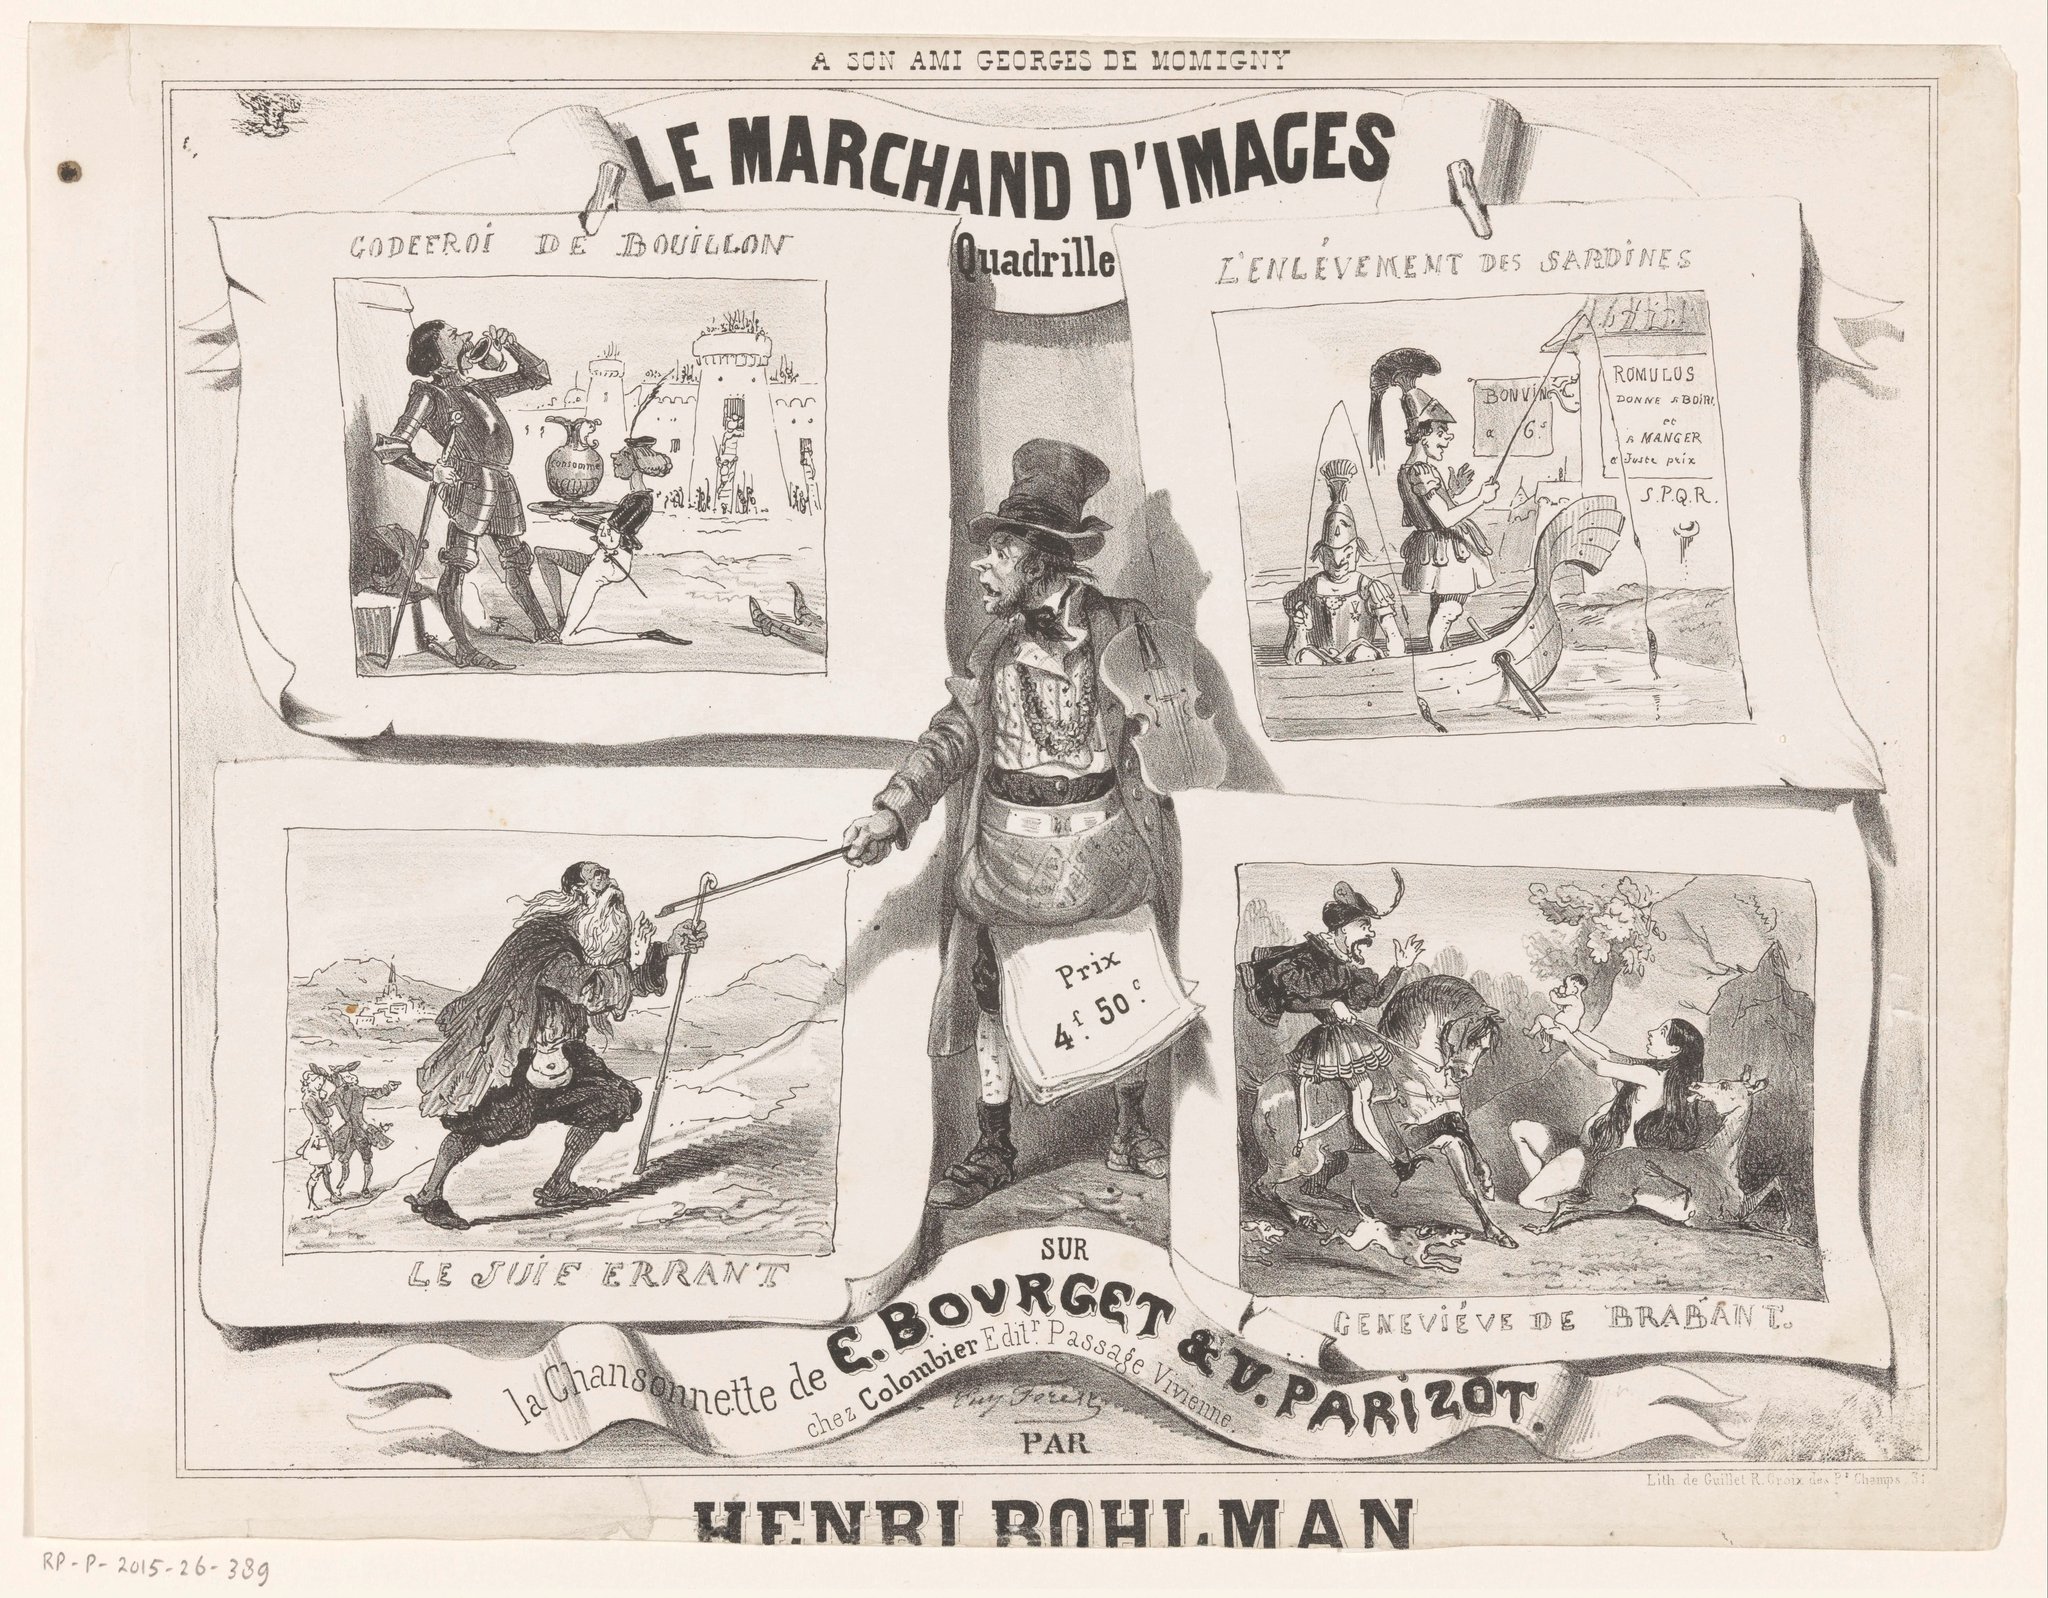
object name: wrapper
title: Prenthandelaar met viool omringd door vier prenten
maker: eugène hippolyte forest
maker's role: print maker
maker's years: 1808-1866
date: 1842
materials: paper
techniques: lithograph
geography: paris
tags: ahasverus, the wandering jew, genoveva, the graphic arts, violin, fiddle, (story of) romulus and remus, godfrey of bouillon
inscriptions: collector's mark: Lugt 2228, collector's mark: Lugt 4779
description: De prenten tonen: Godfried van Bouillon die een beker bouillon drinkt, Romulus en Remus die vissen op sardines (een persiflage op de Sabijnse maagdenroof), de Wandelende Jood en een jager die tijdens de achtervolging van een aangeschoten hert Genoveva van Brabant met haar kind tegenkomt.